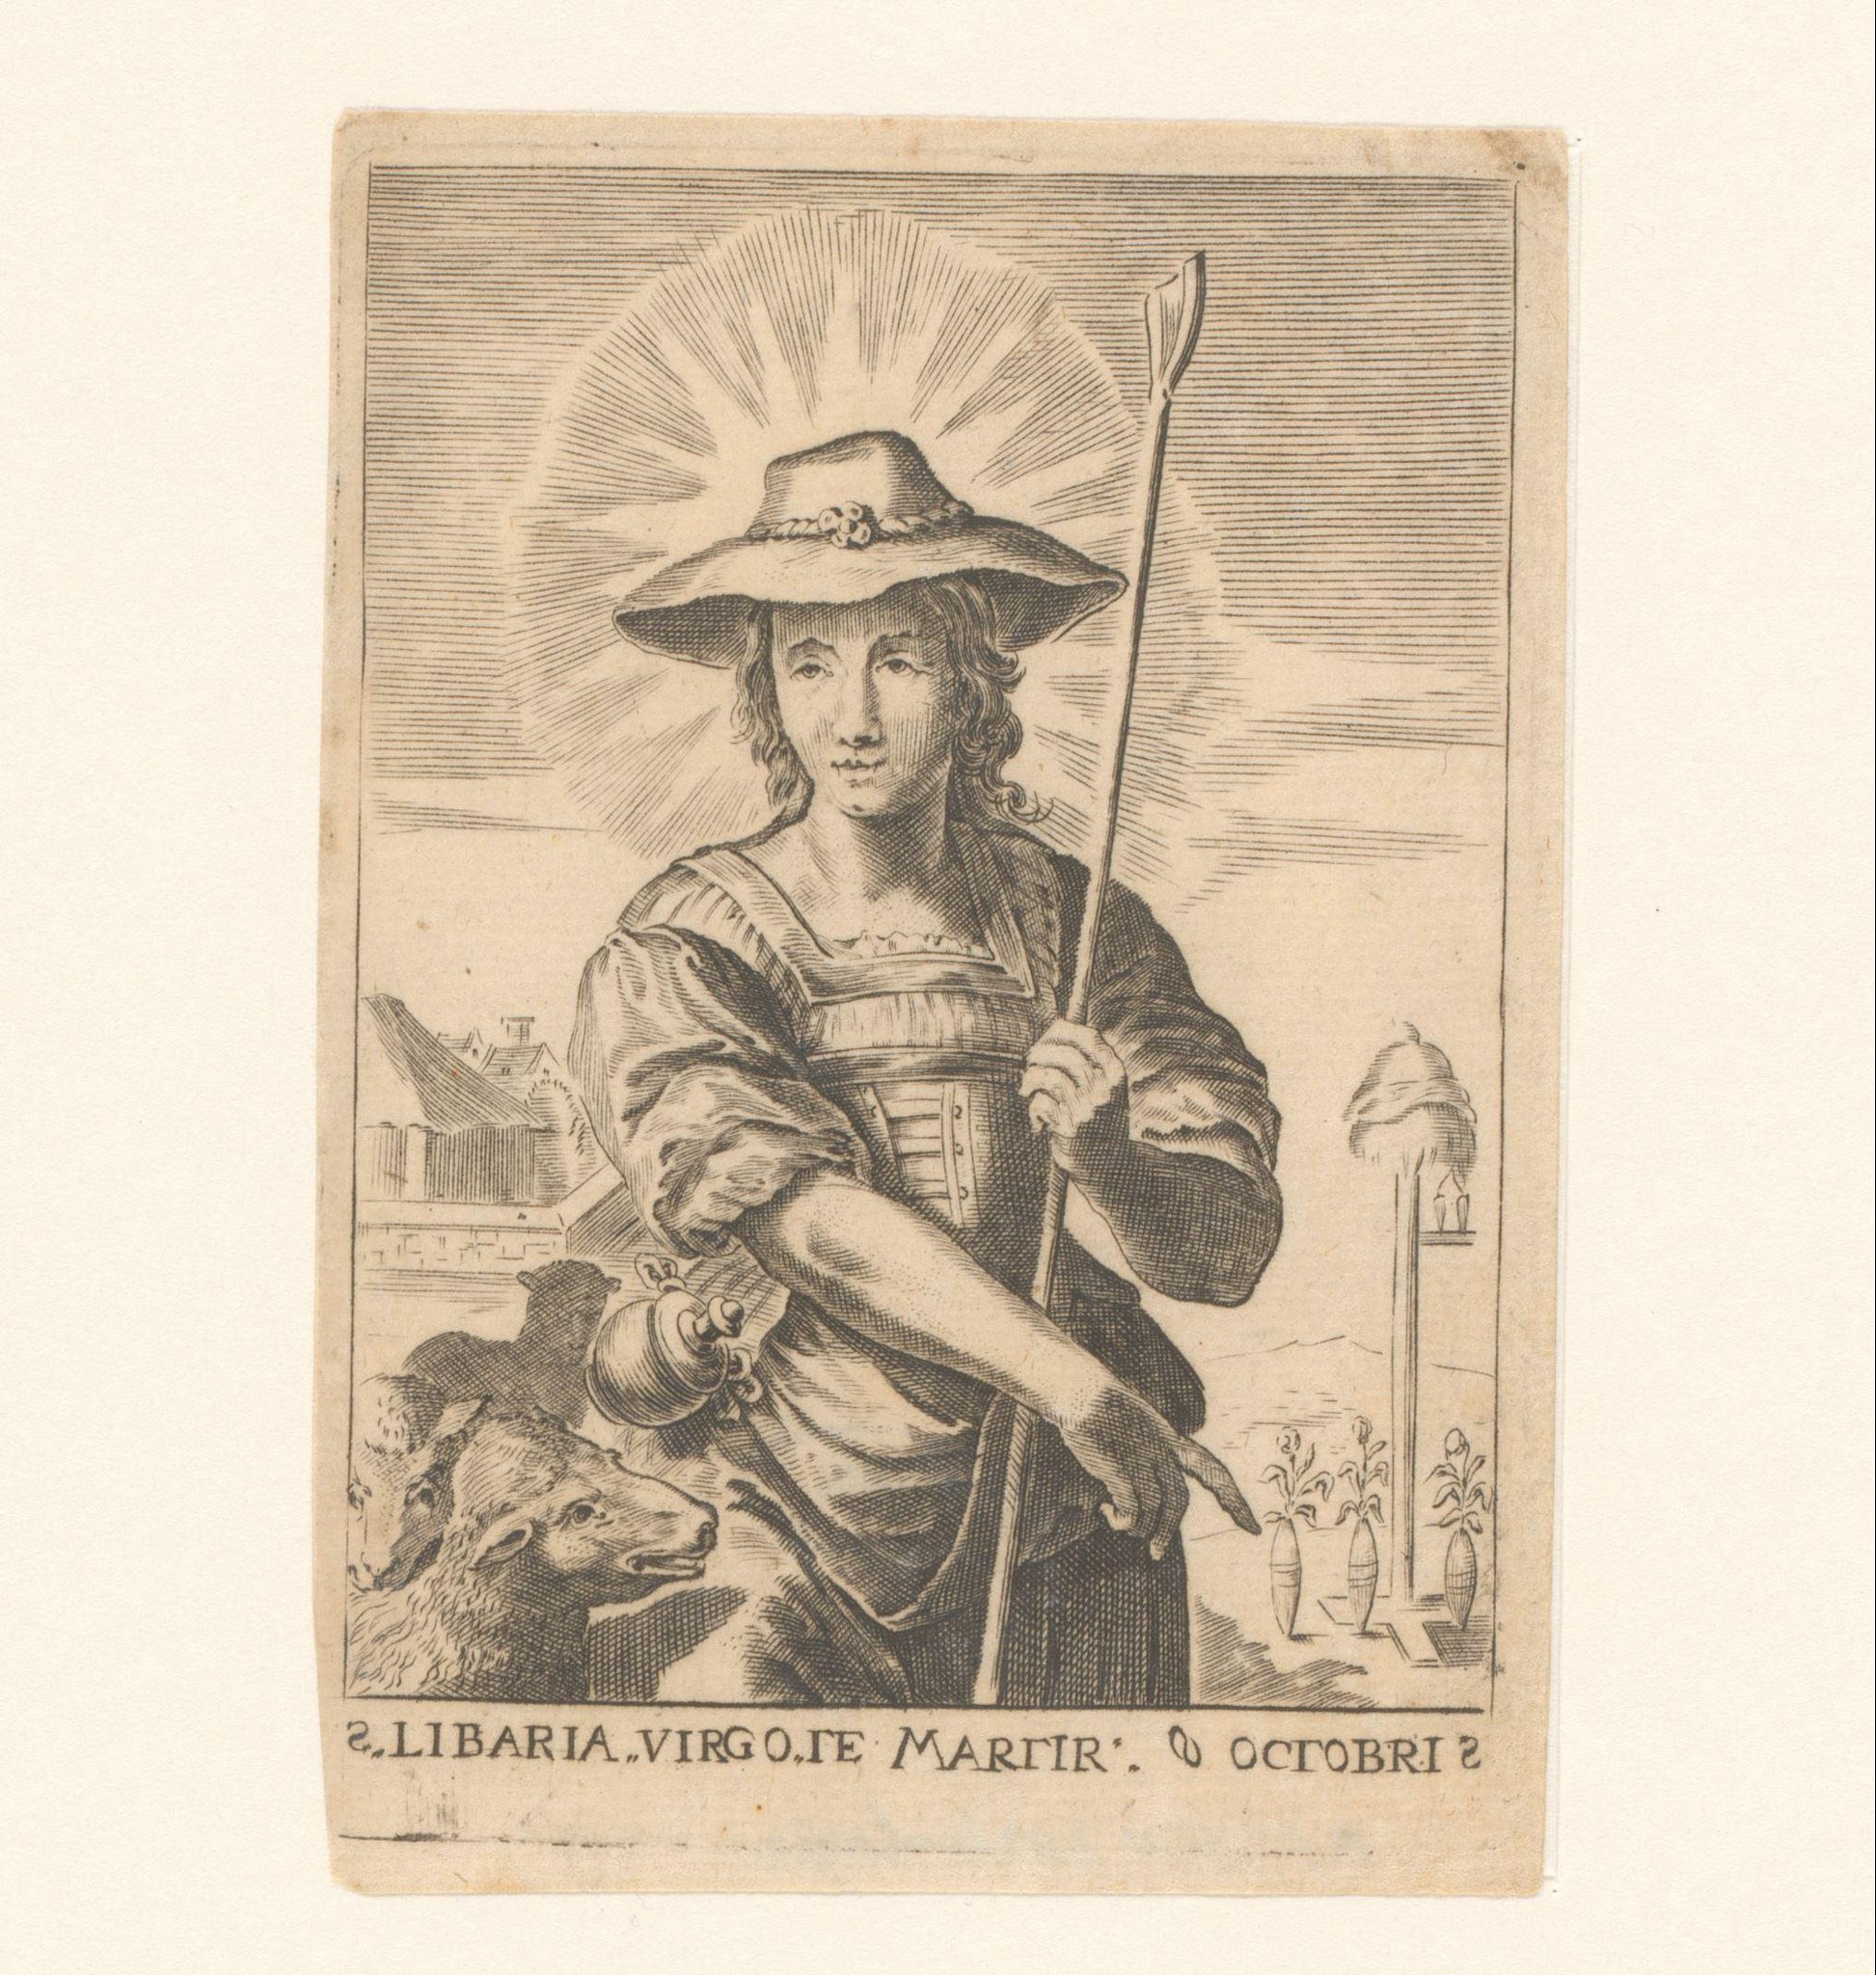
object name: print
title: Vrouwelijke heiligen en hun naamdagen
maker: Anonymous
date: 1600-1699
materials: paper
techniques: engraving, etching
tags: herding, herdsman, herdswoman, shepherd, shepherdess, cowherd, etc., female saints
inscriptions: collector's mark: Lugt 2228